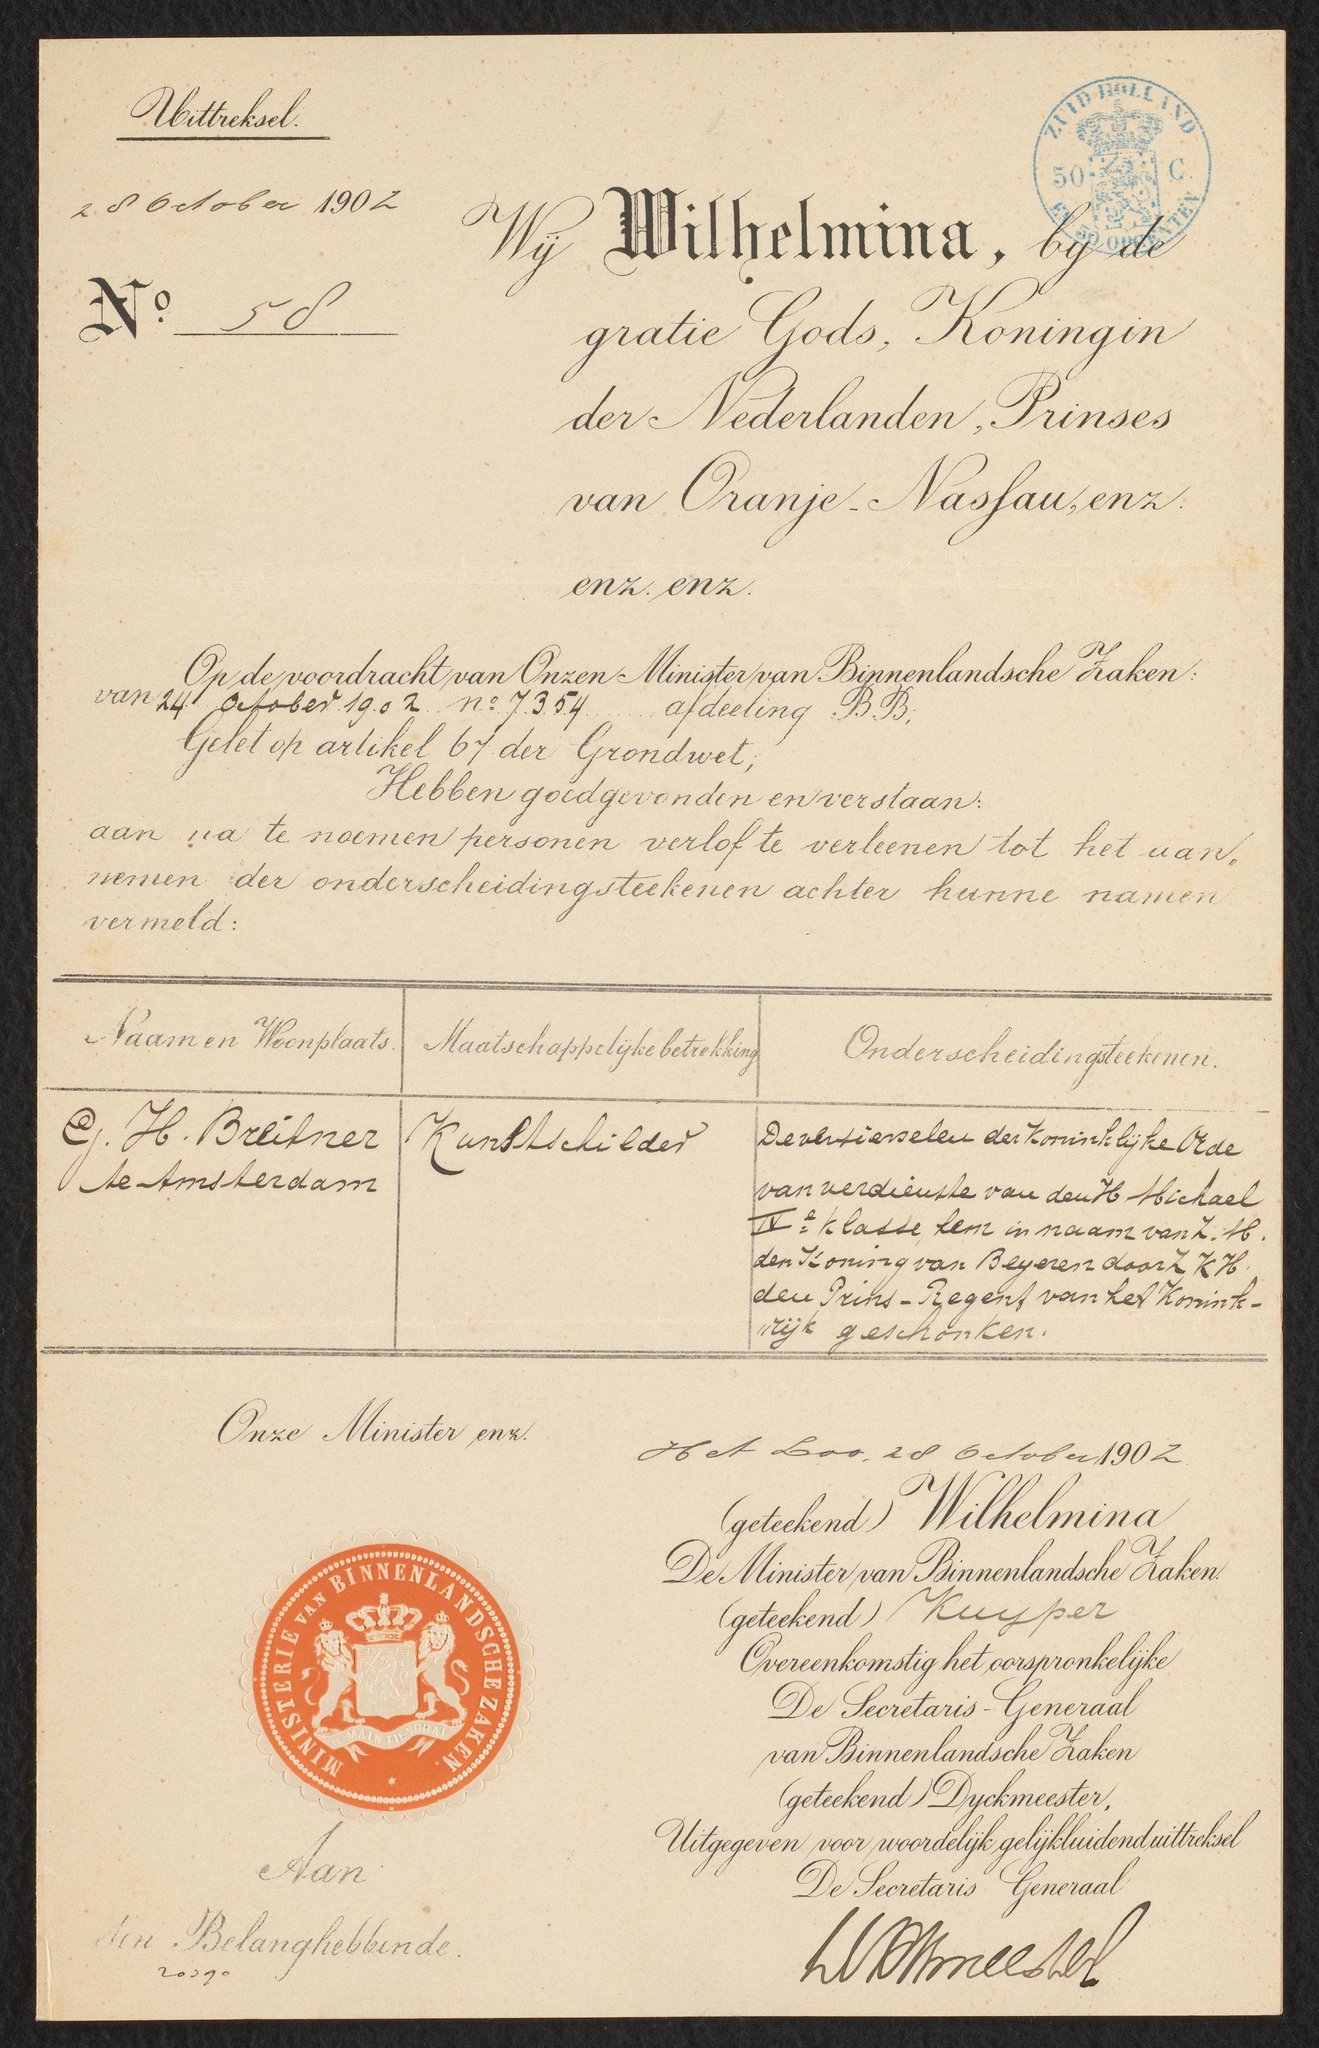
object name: document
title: Uittreksel betreffende de benoeming van George Hendrik Breitner als ridder in de Orde van Leopold, ondertekend door verschillende Nederlandse hoogwaardigheidsbekleders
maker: Anonymous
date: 1902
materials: ink, paper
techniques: printing, letterpress printing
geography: the hague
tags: rotterdam, amsterdam, painter, print maker, draughtsman, george hendrik breitner, distribution of awards ~ art contest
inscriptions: inscription: ‘Zegel f 75,-’